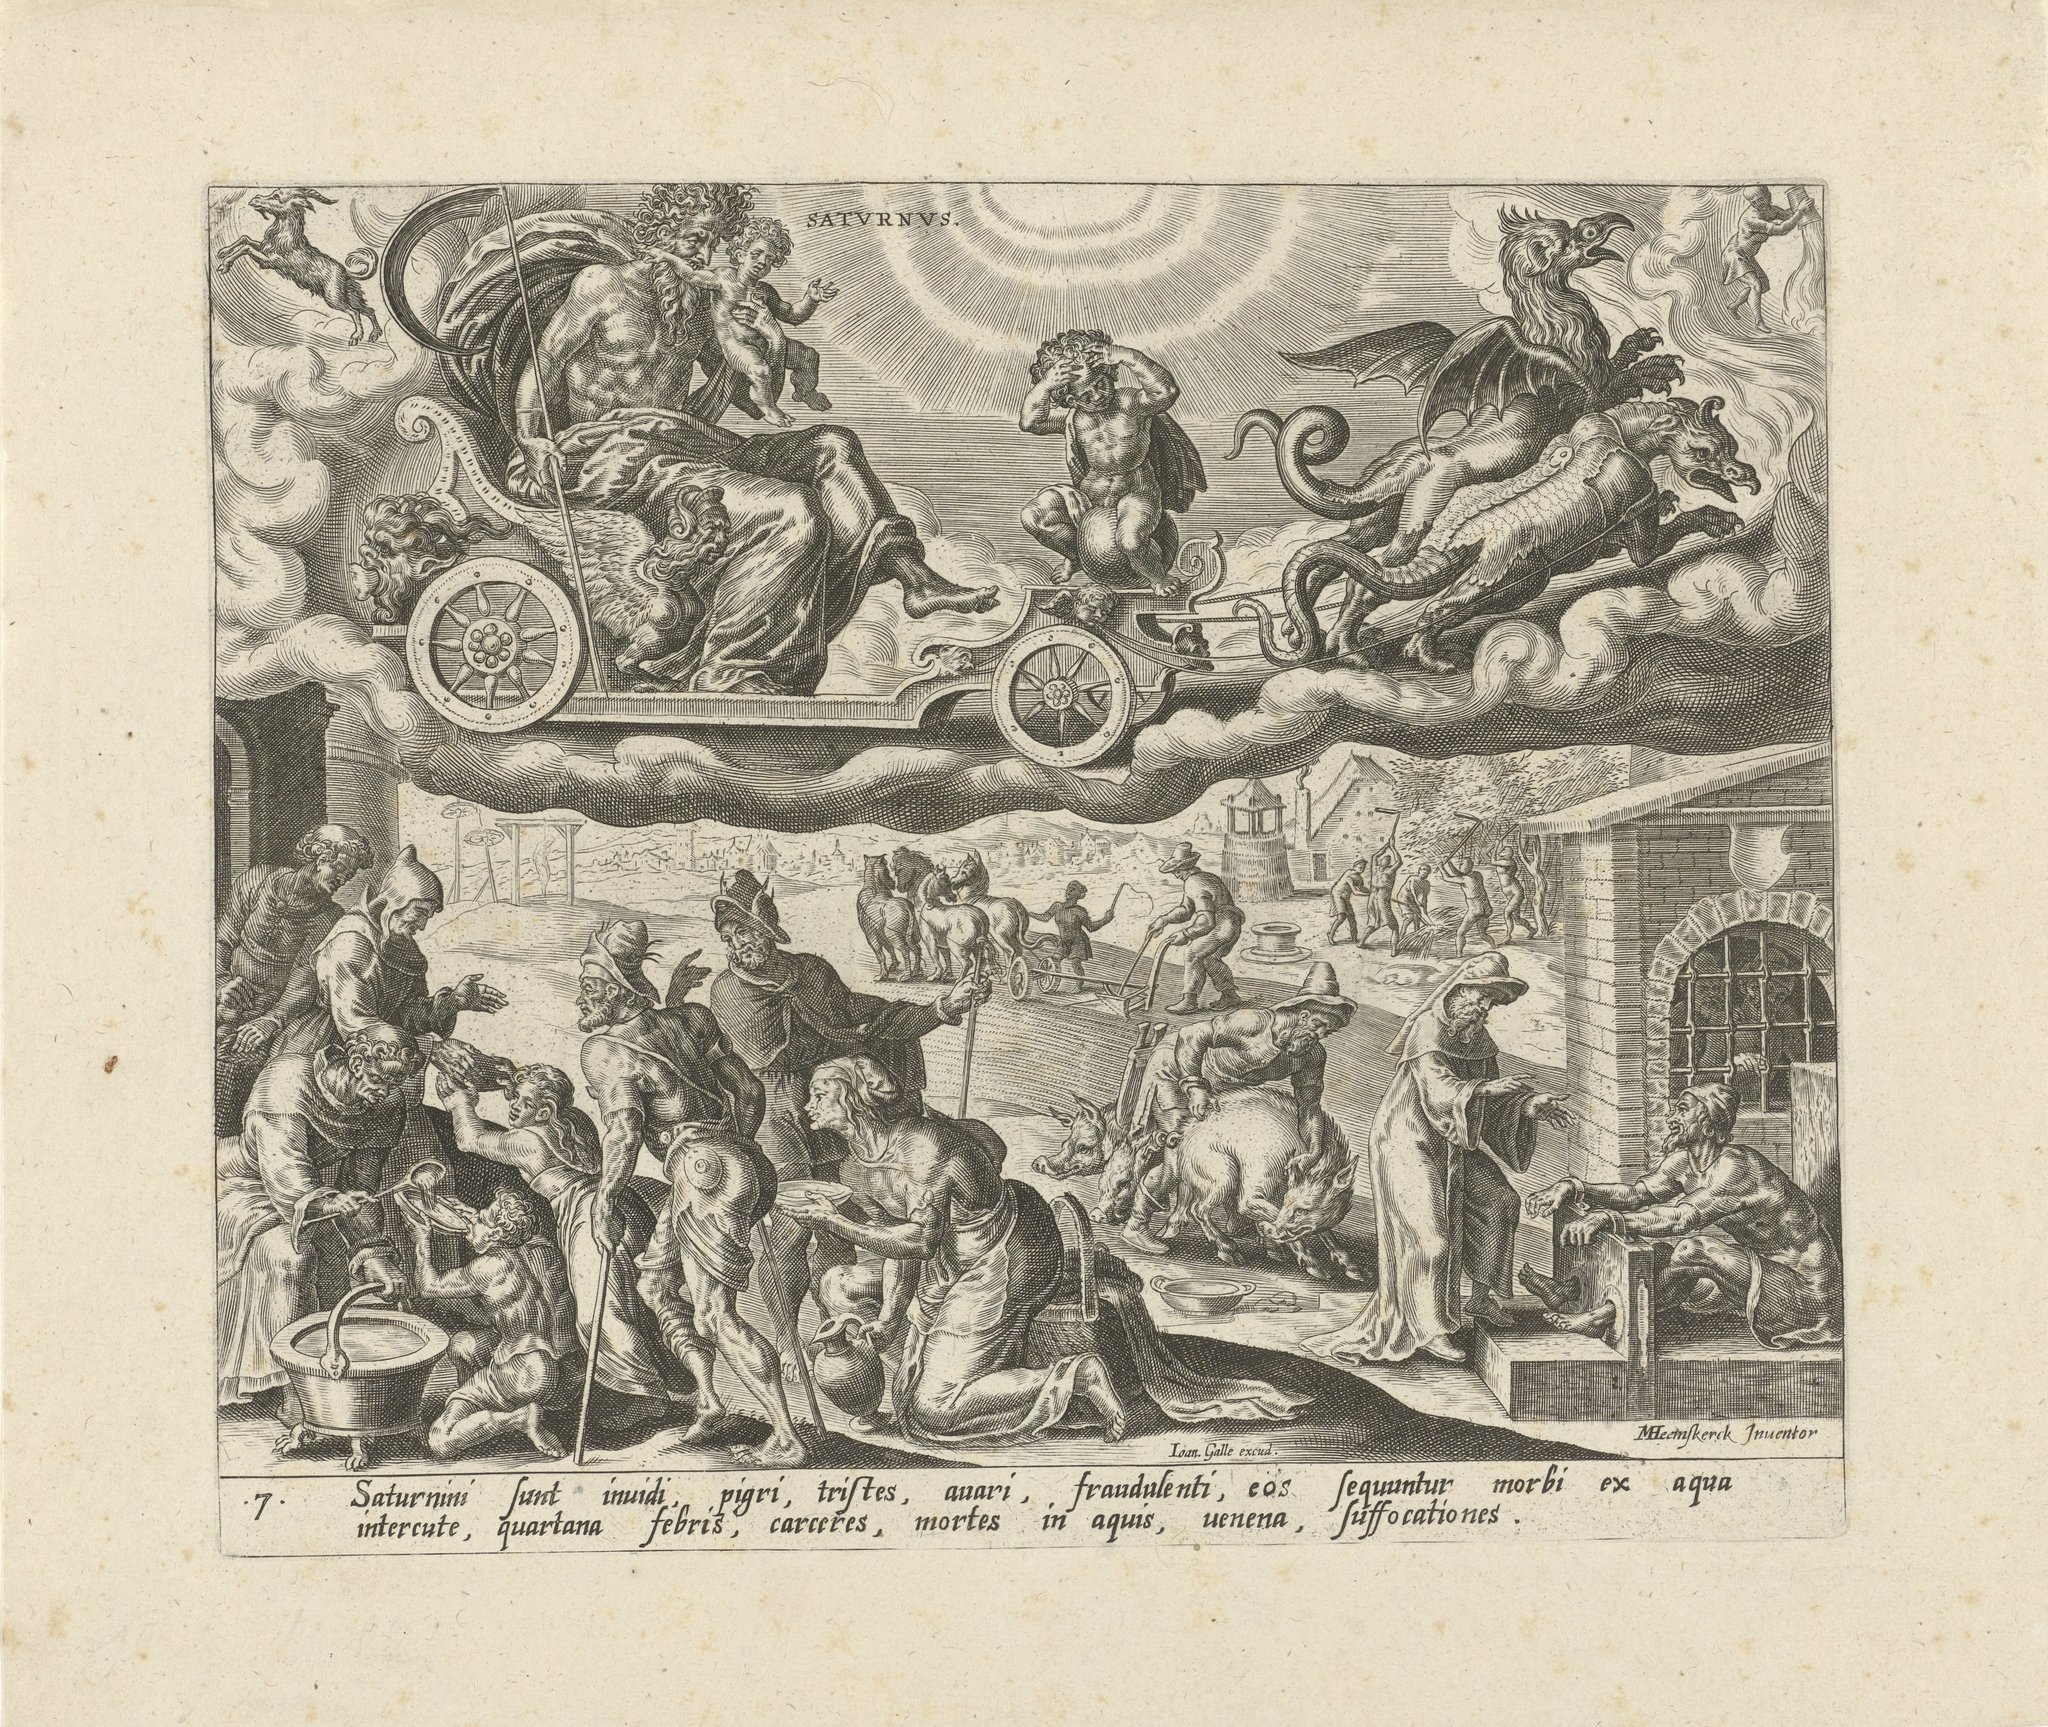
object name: print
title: De zeven planeten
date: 1566-1570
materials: paper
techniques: engraving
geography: antwerp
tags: prison, jail, saturn and his children ('planetenkinder') ~ aquarius and capricorn, dragon, agriculture, charitable works, the poor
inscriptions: collector's mark: Lugt 2228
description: Saturnus rijdt in zijn wagen aan de hemel, getrokken door twee draken. Hij verslindt een van zijn kinderen. De tekens van Steenbok en Waterman geven aan welke mensen tot de invloedssfeer van Saturnus behoren. De mensen, die onder dit sterrenbeeld geboren zijn, hebben een slechte gezondheid en kennen geen gelukkig levenseinde. Links halen arme kinderen, een bedelaar op krukken, pelgrim en hongerige vrouw eten bij liefdadige monniken. Rechts mensen in de gevangenis, die bezocht worden door een man. Op de achtergrond wordt het land bewerkt. Onderaan in de marge een tekst in het Latijn over de kinderen van Saturnus.